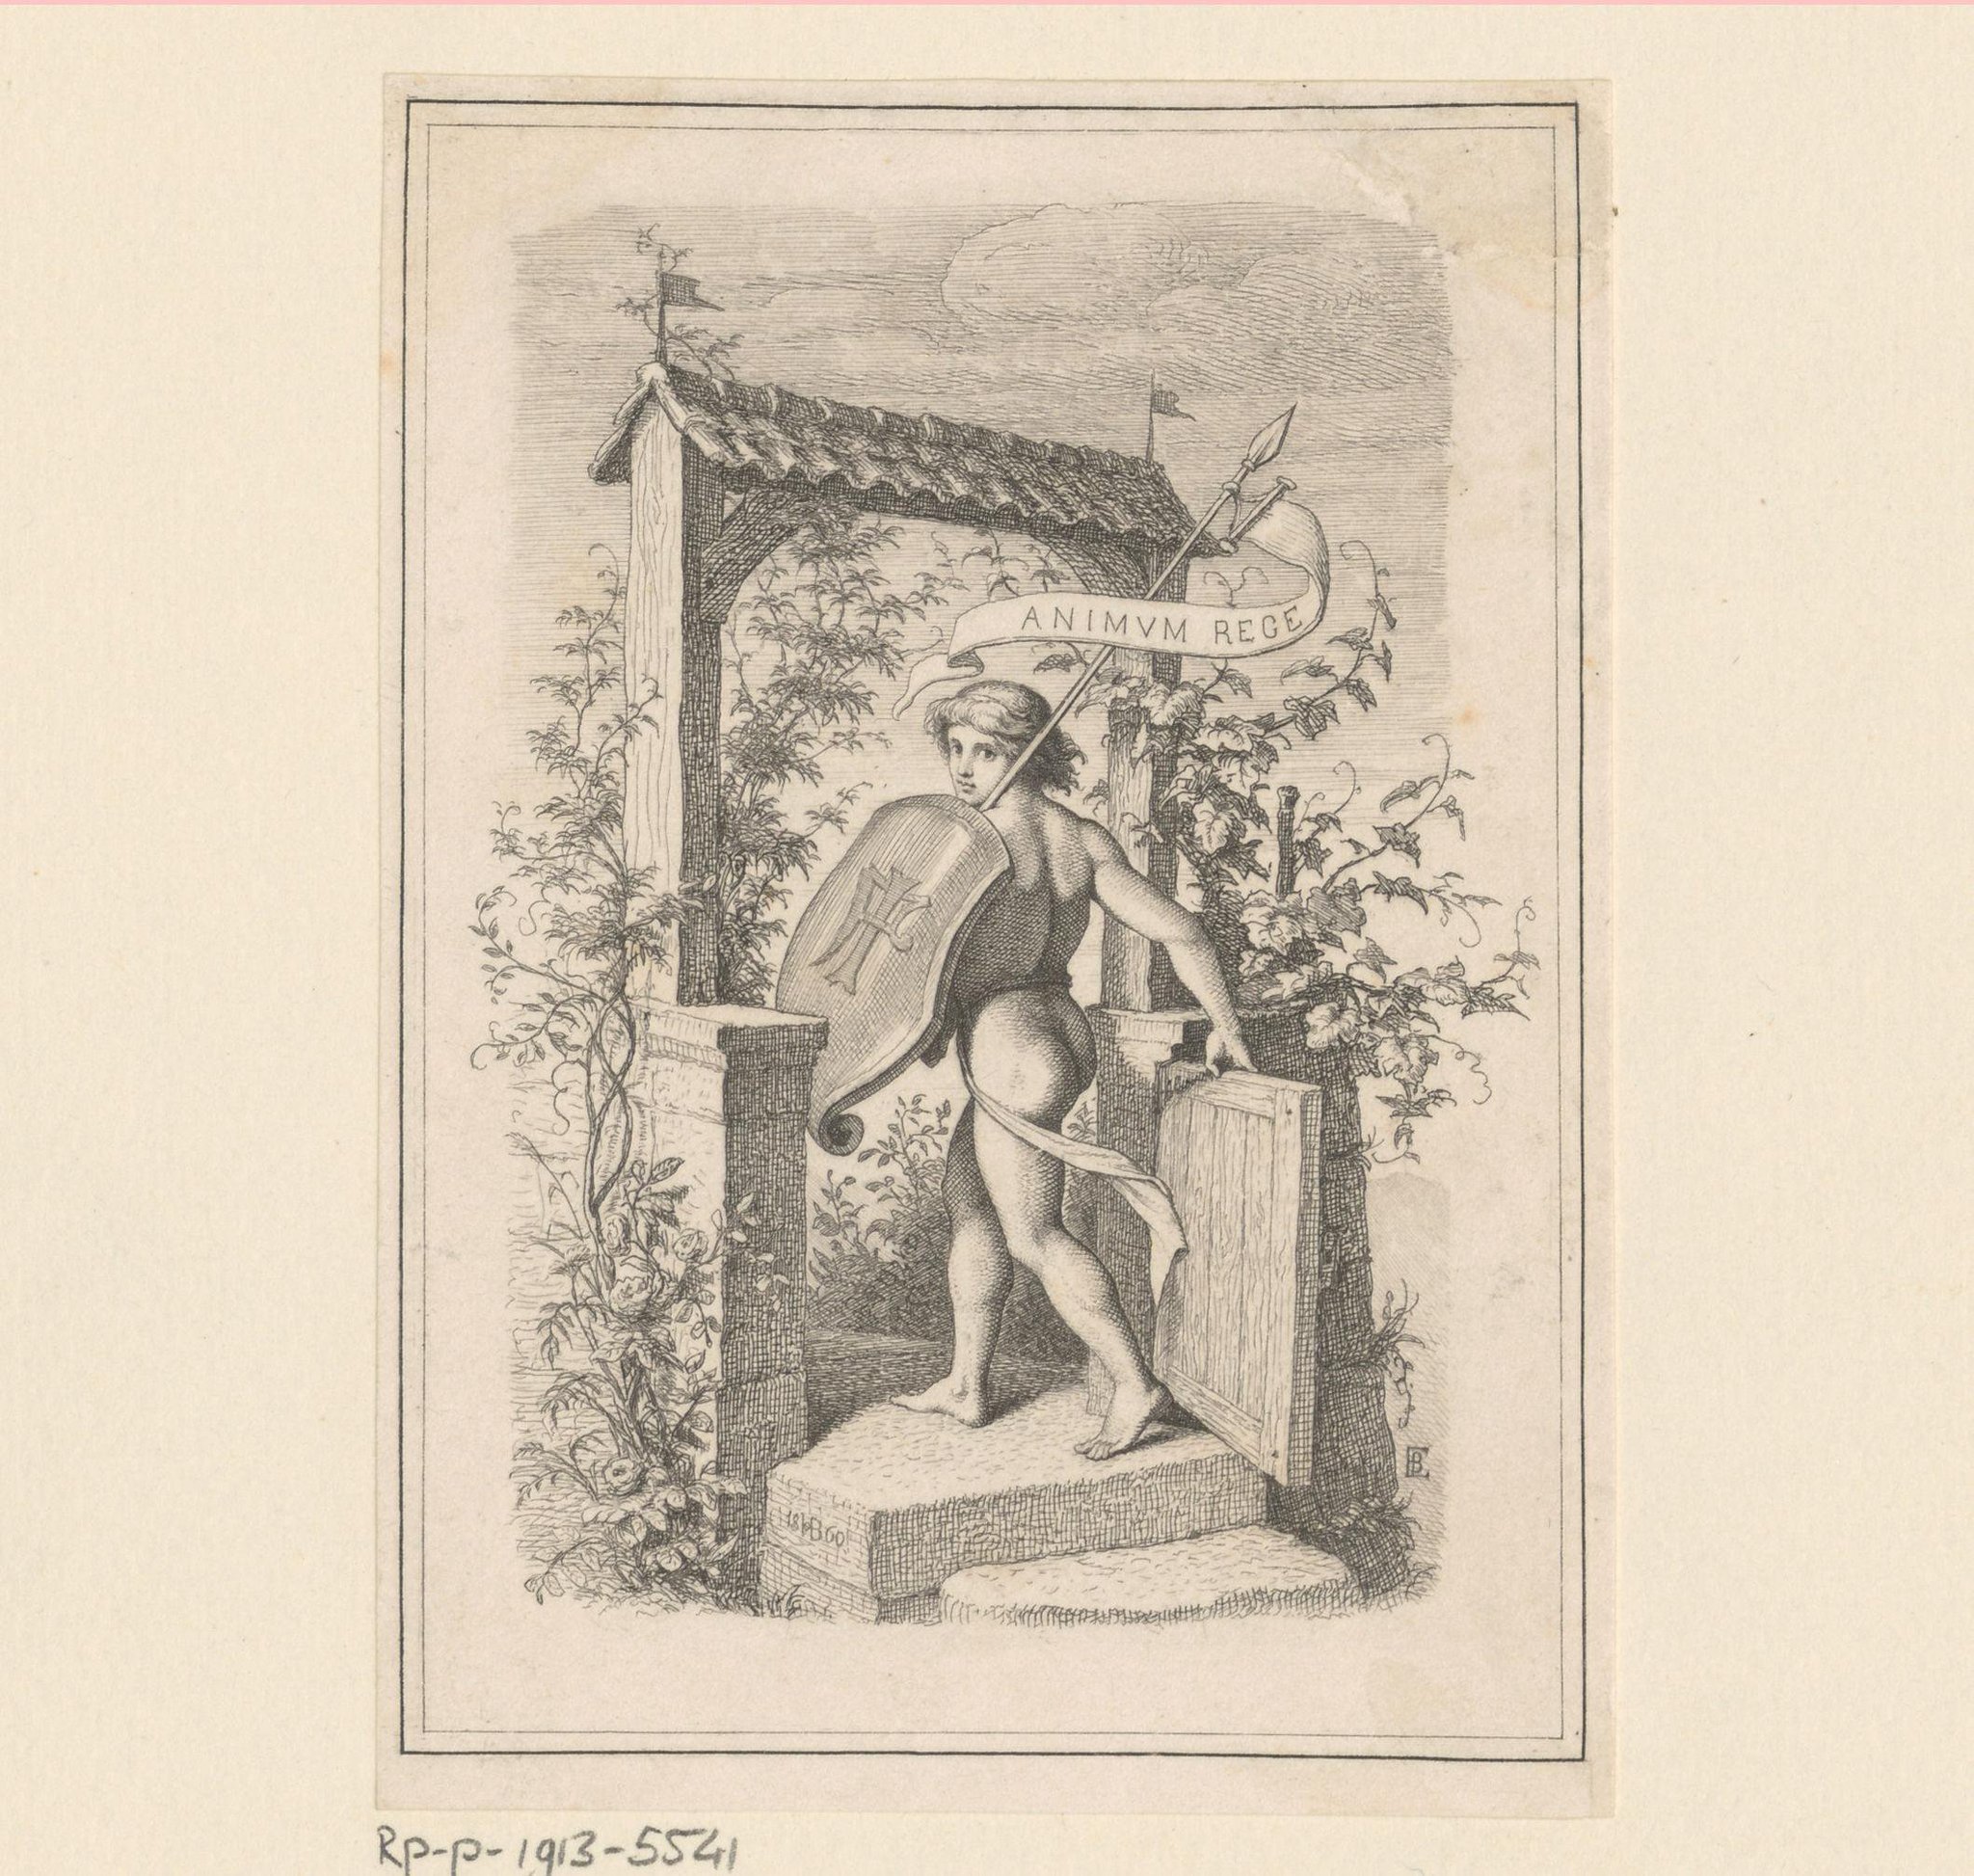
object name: bookplate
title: Animum rege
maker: Anonymous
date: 1860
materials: paper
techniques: etching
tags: shield-bearer, squire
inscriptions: collector's mark: Lugt 2760, collector's mark: Lugt 2233, monogram: ‘EB’